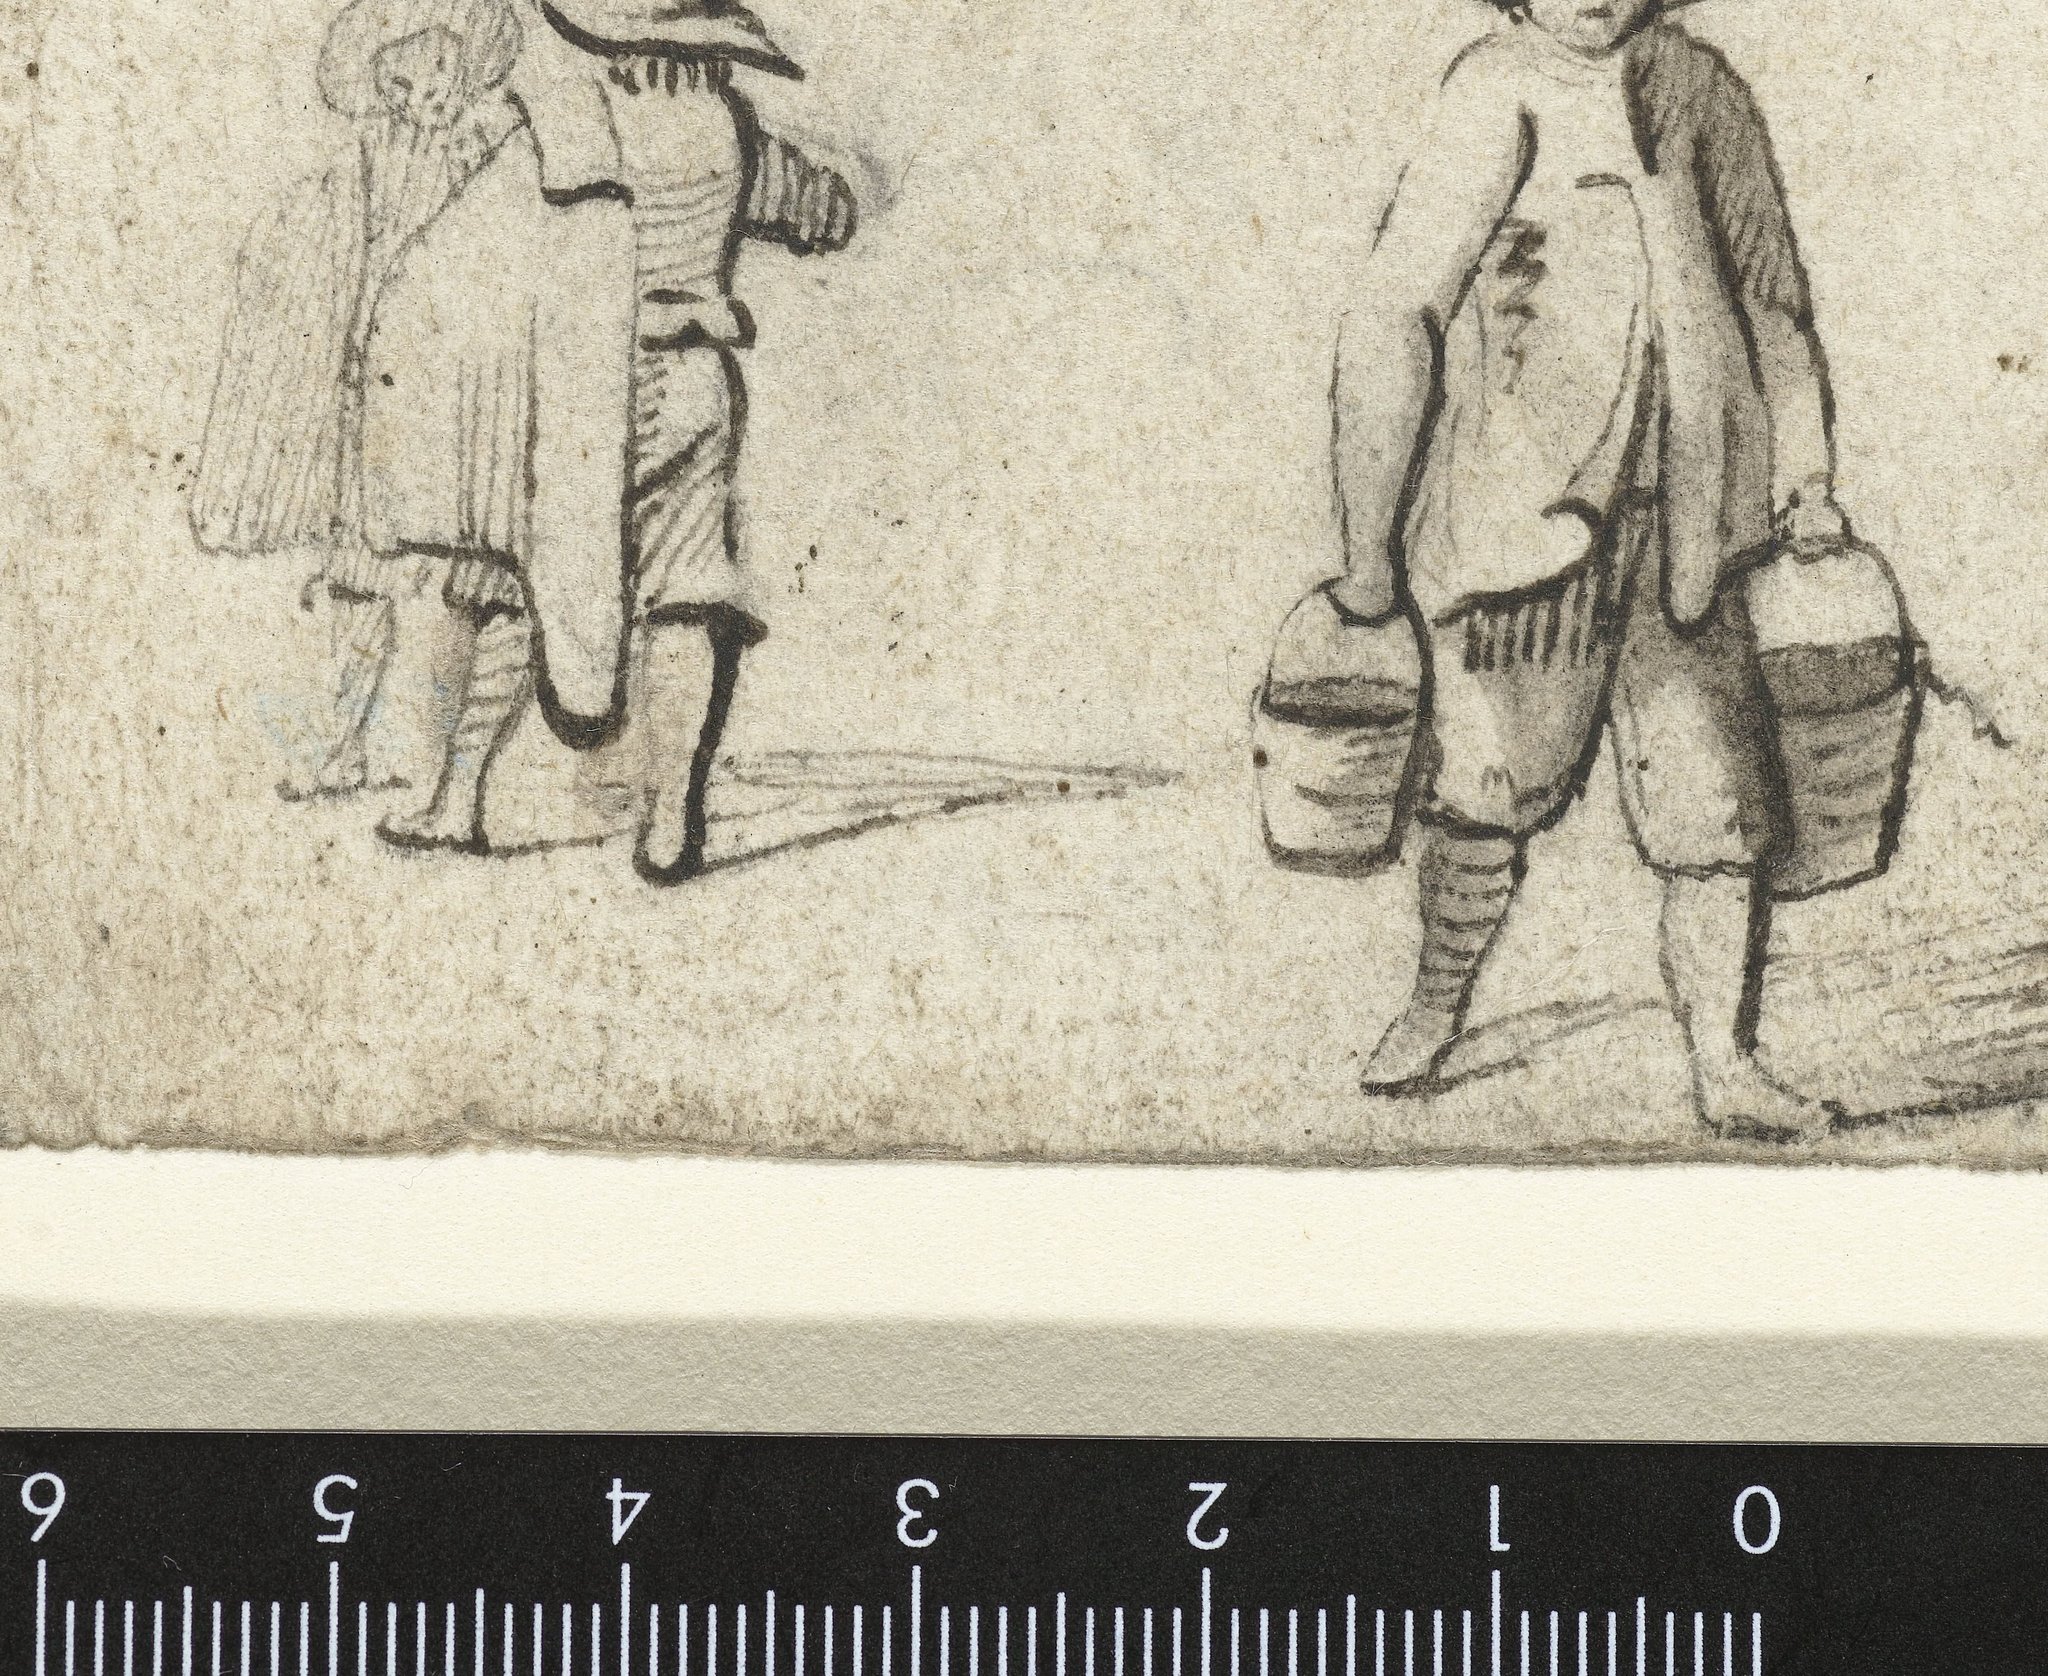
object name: drawing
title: Drie staande figuren, de voorste draagt emmers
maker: harmen ter borch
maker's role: draughtsman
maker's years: 1638-1677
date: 1612-1649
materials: chalk, ink, paper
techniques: brush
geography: zwolle